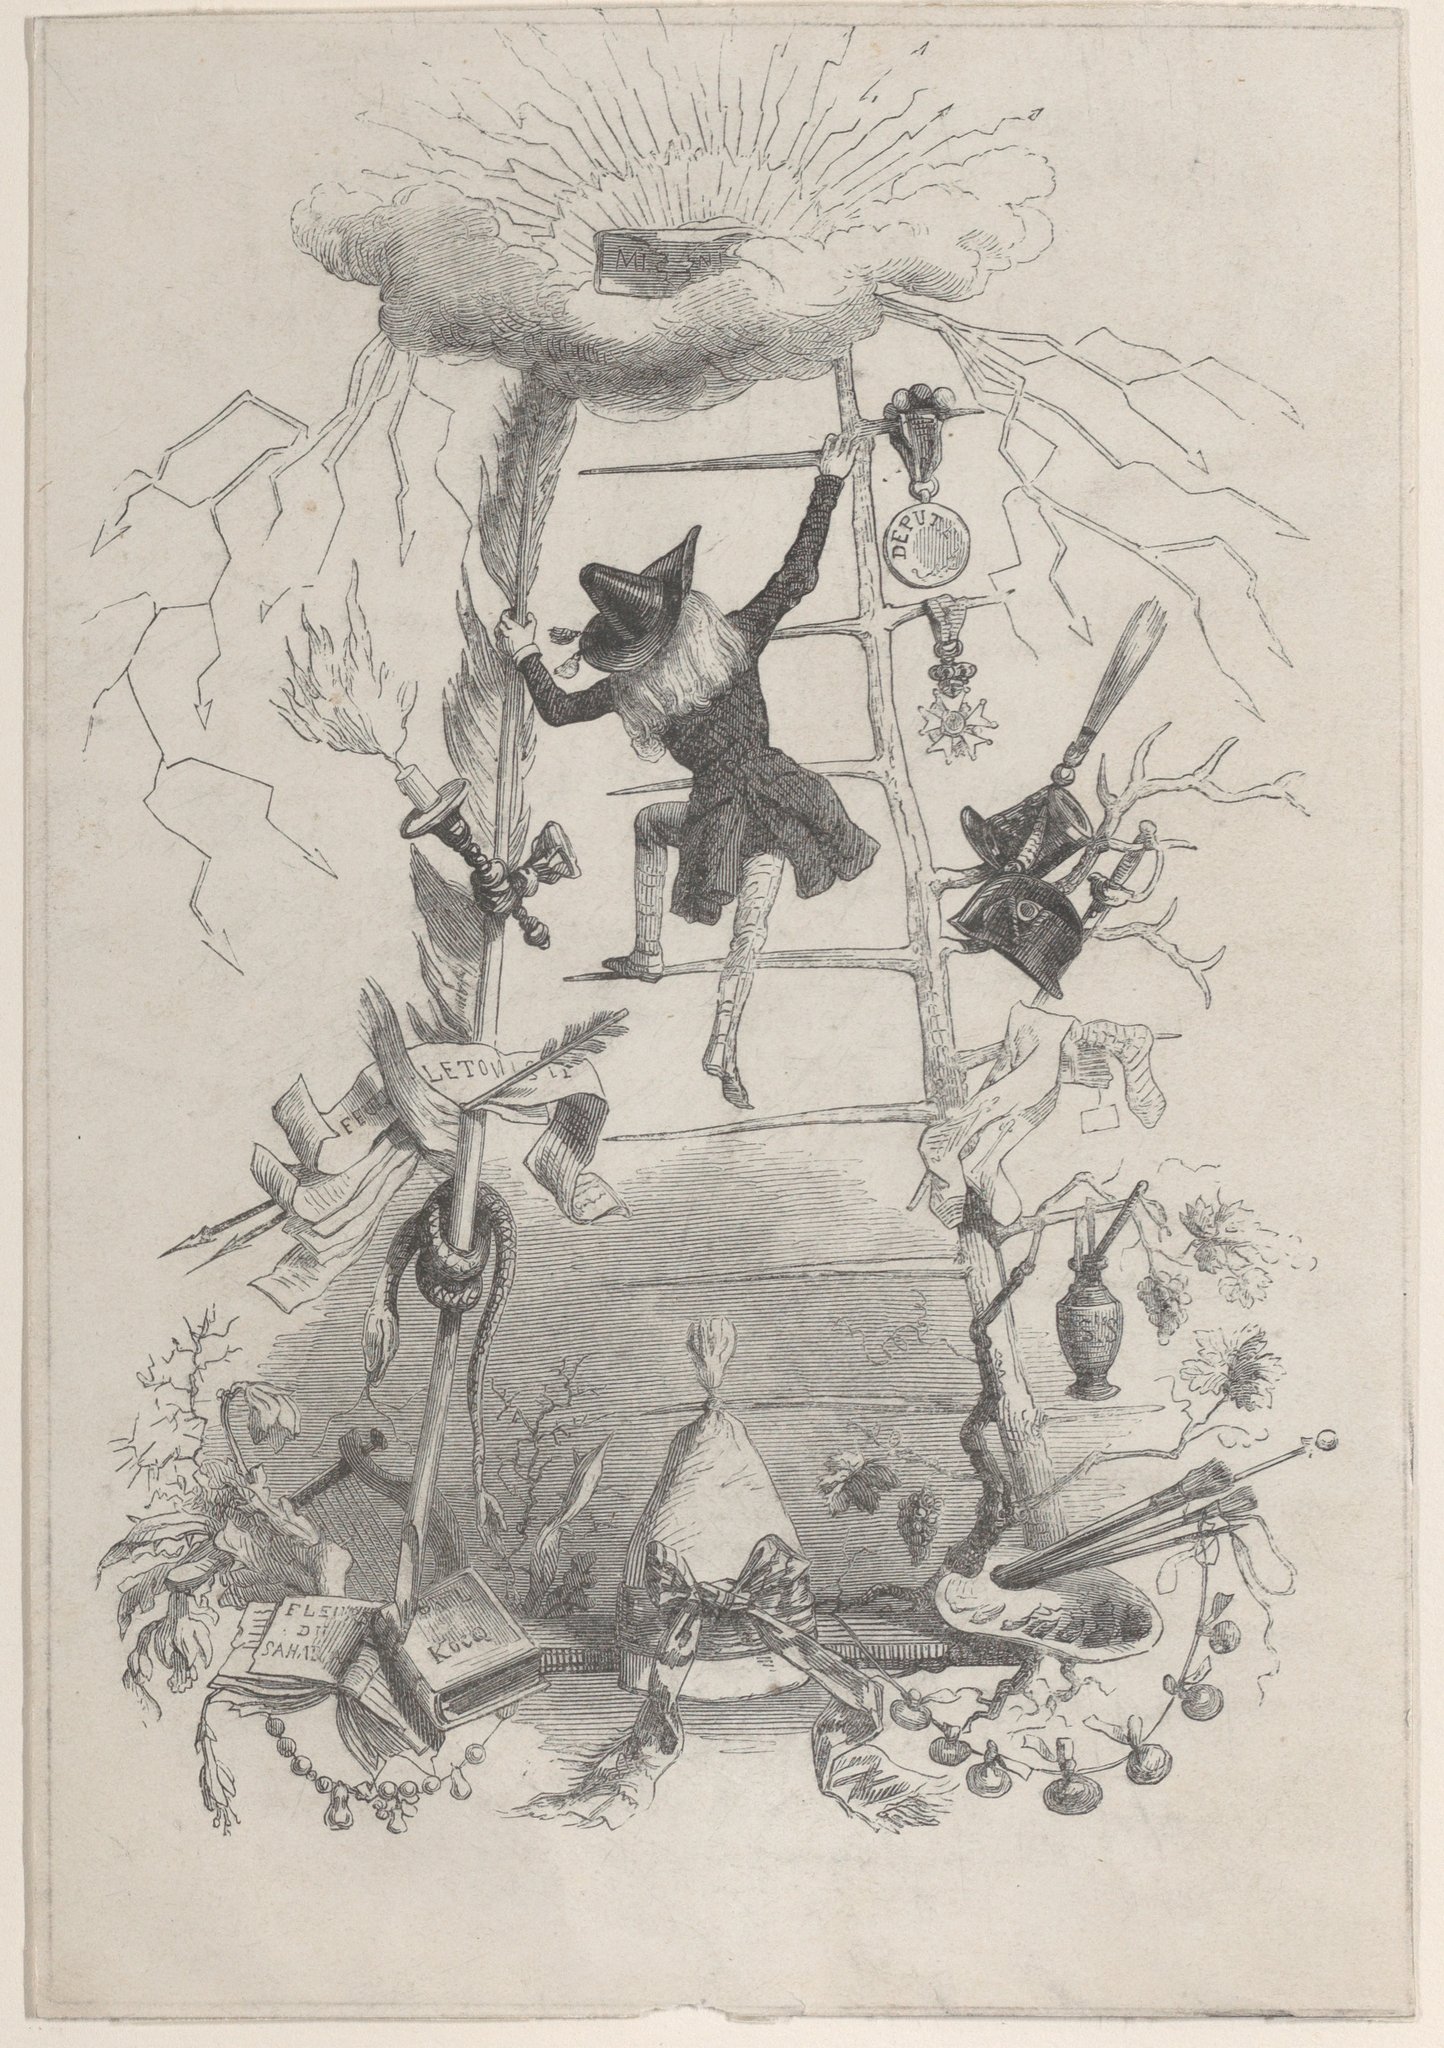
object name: print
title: Illustration in Jérôme Paturot, by Louis Reybaud, Paris, 1846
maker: j. j. grandville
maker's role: artist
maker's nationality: french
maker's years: 1803-1847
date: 1846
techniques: engraving